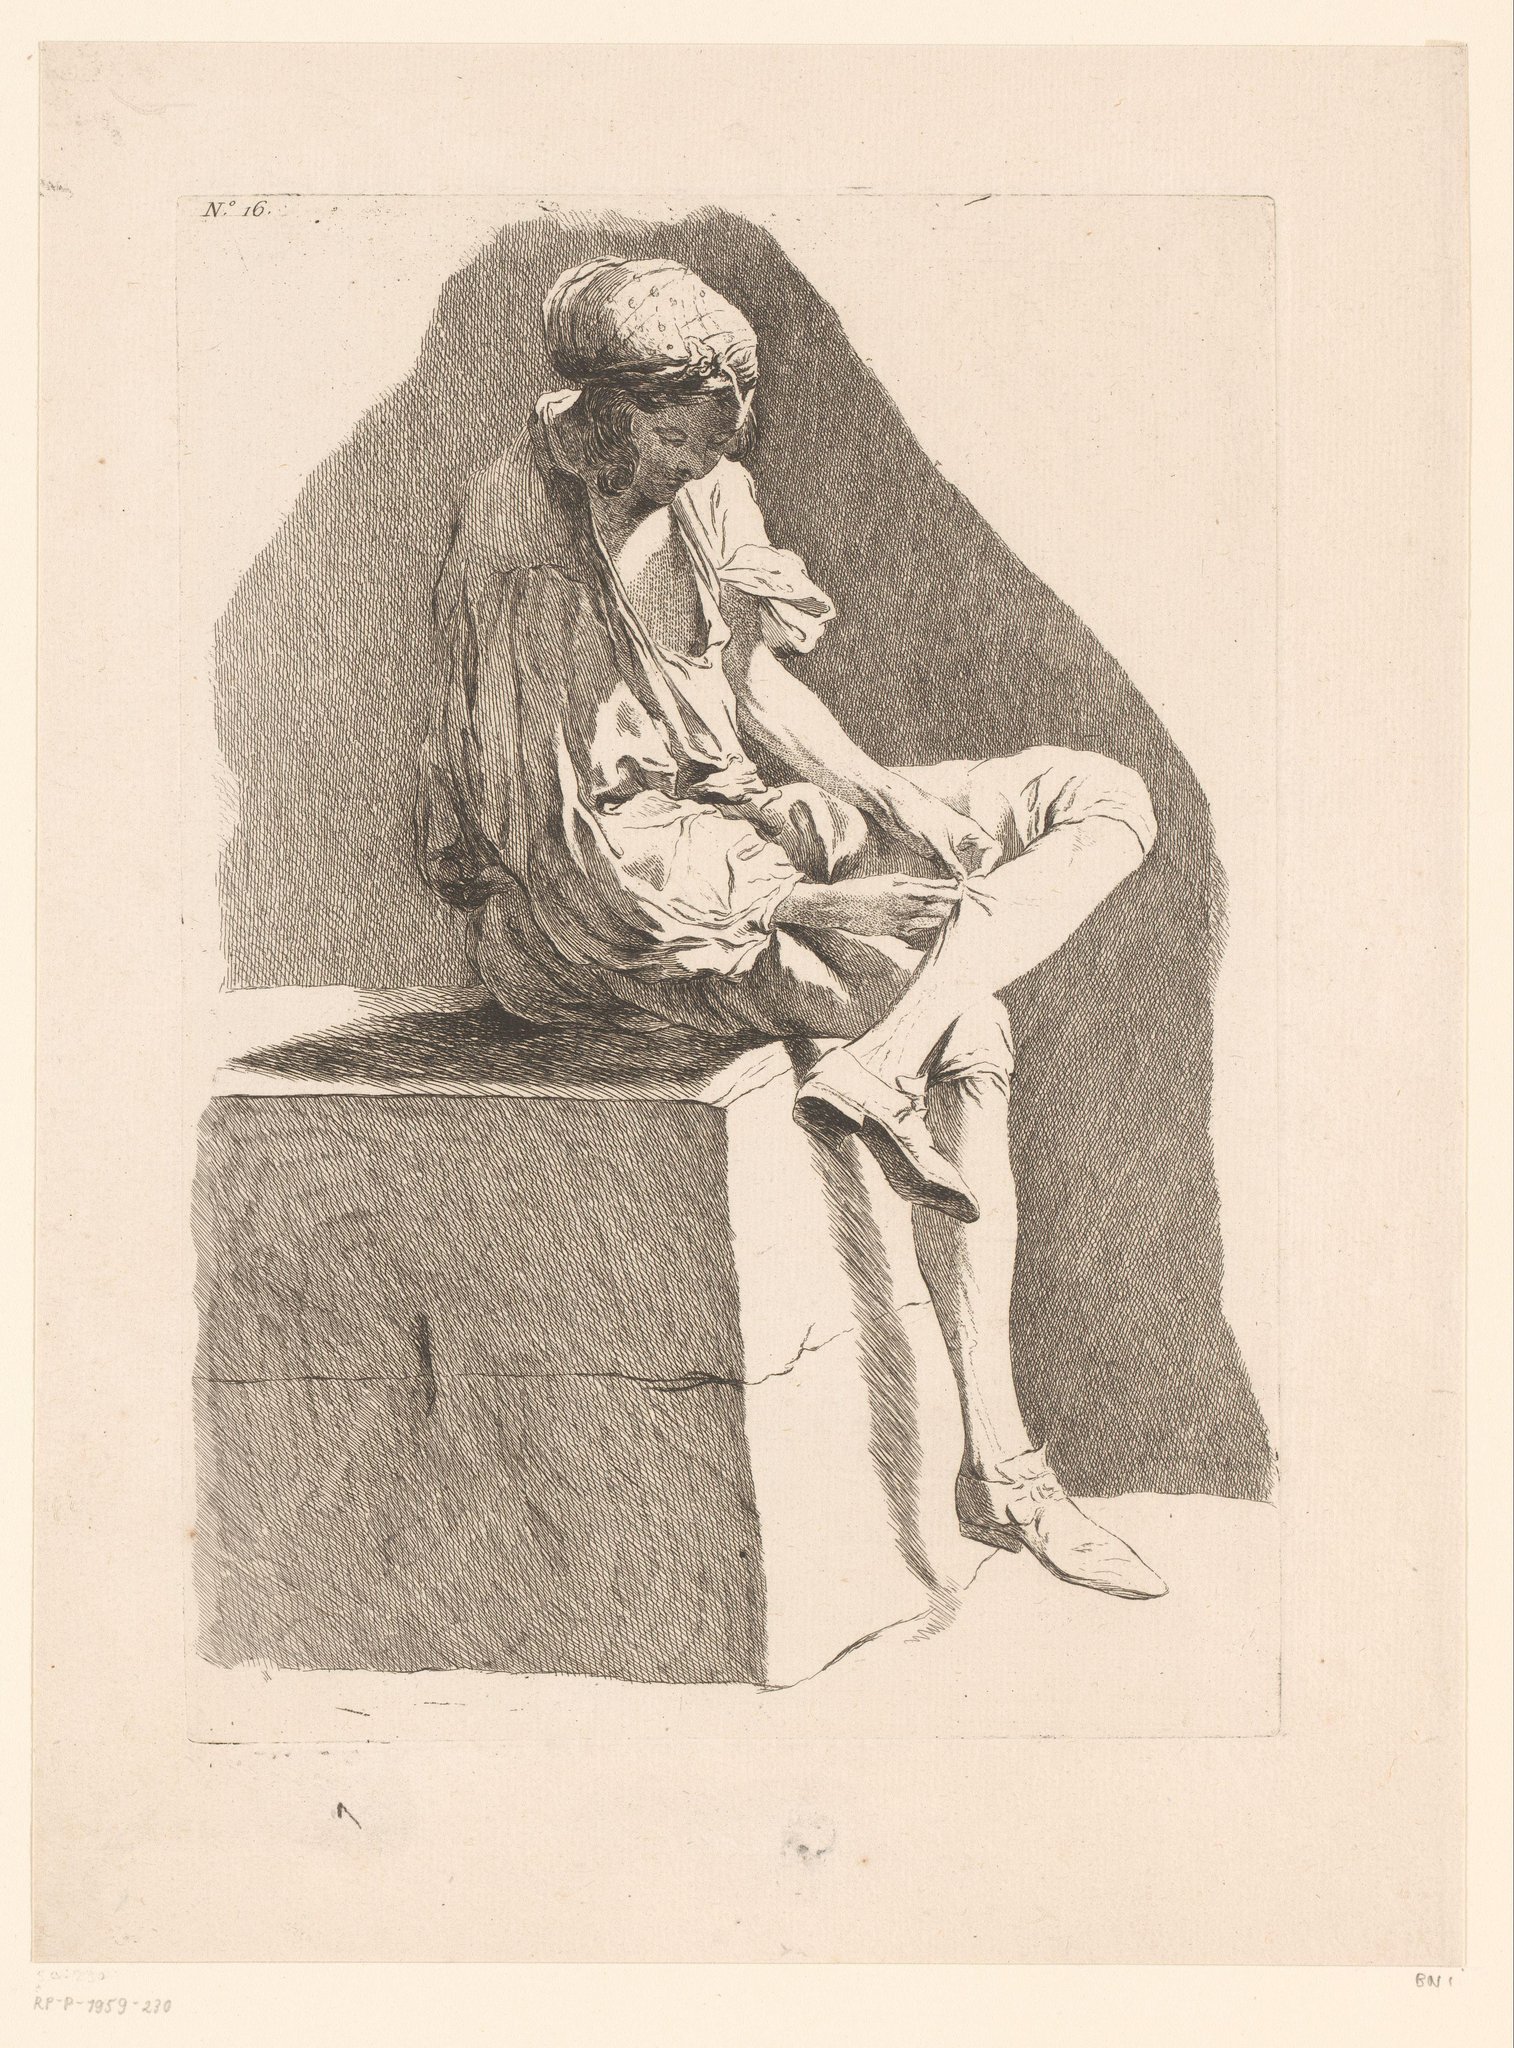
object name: print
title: Karikatuur van een jongen die zijn kous naait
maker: ange laurent de lalive de jully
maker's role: print maker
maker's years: 1725-1779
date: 1745-1779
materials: paper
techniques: etching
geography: france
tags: caricatures (human types), stockings, socks (+ worn or torn clothes)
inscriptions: collector's mark: Lugt 2228, collector's mark: Lugt 2760